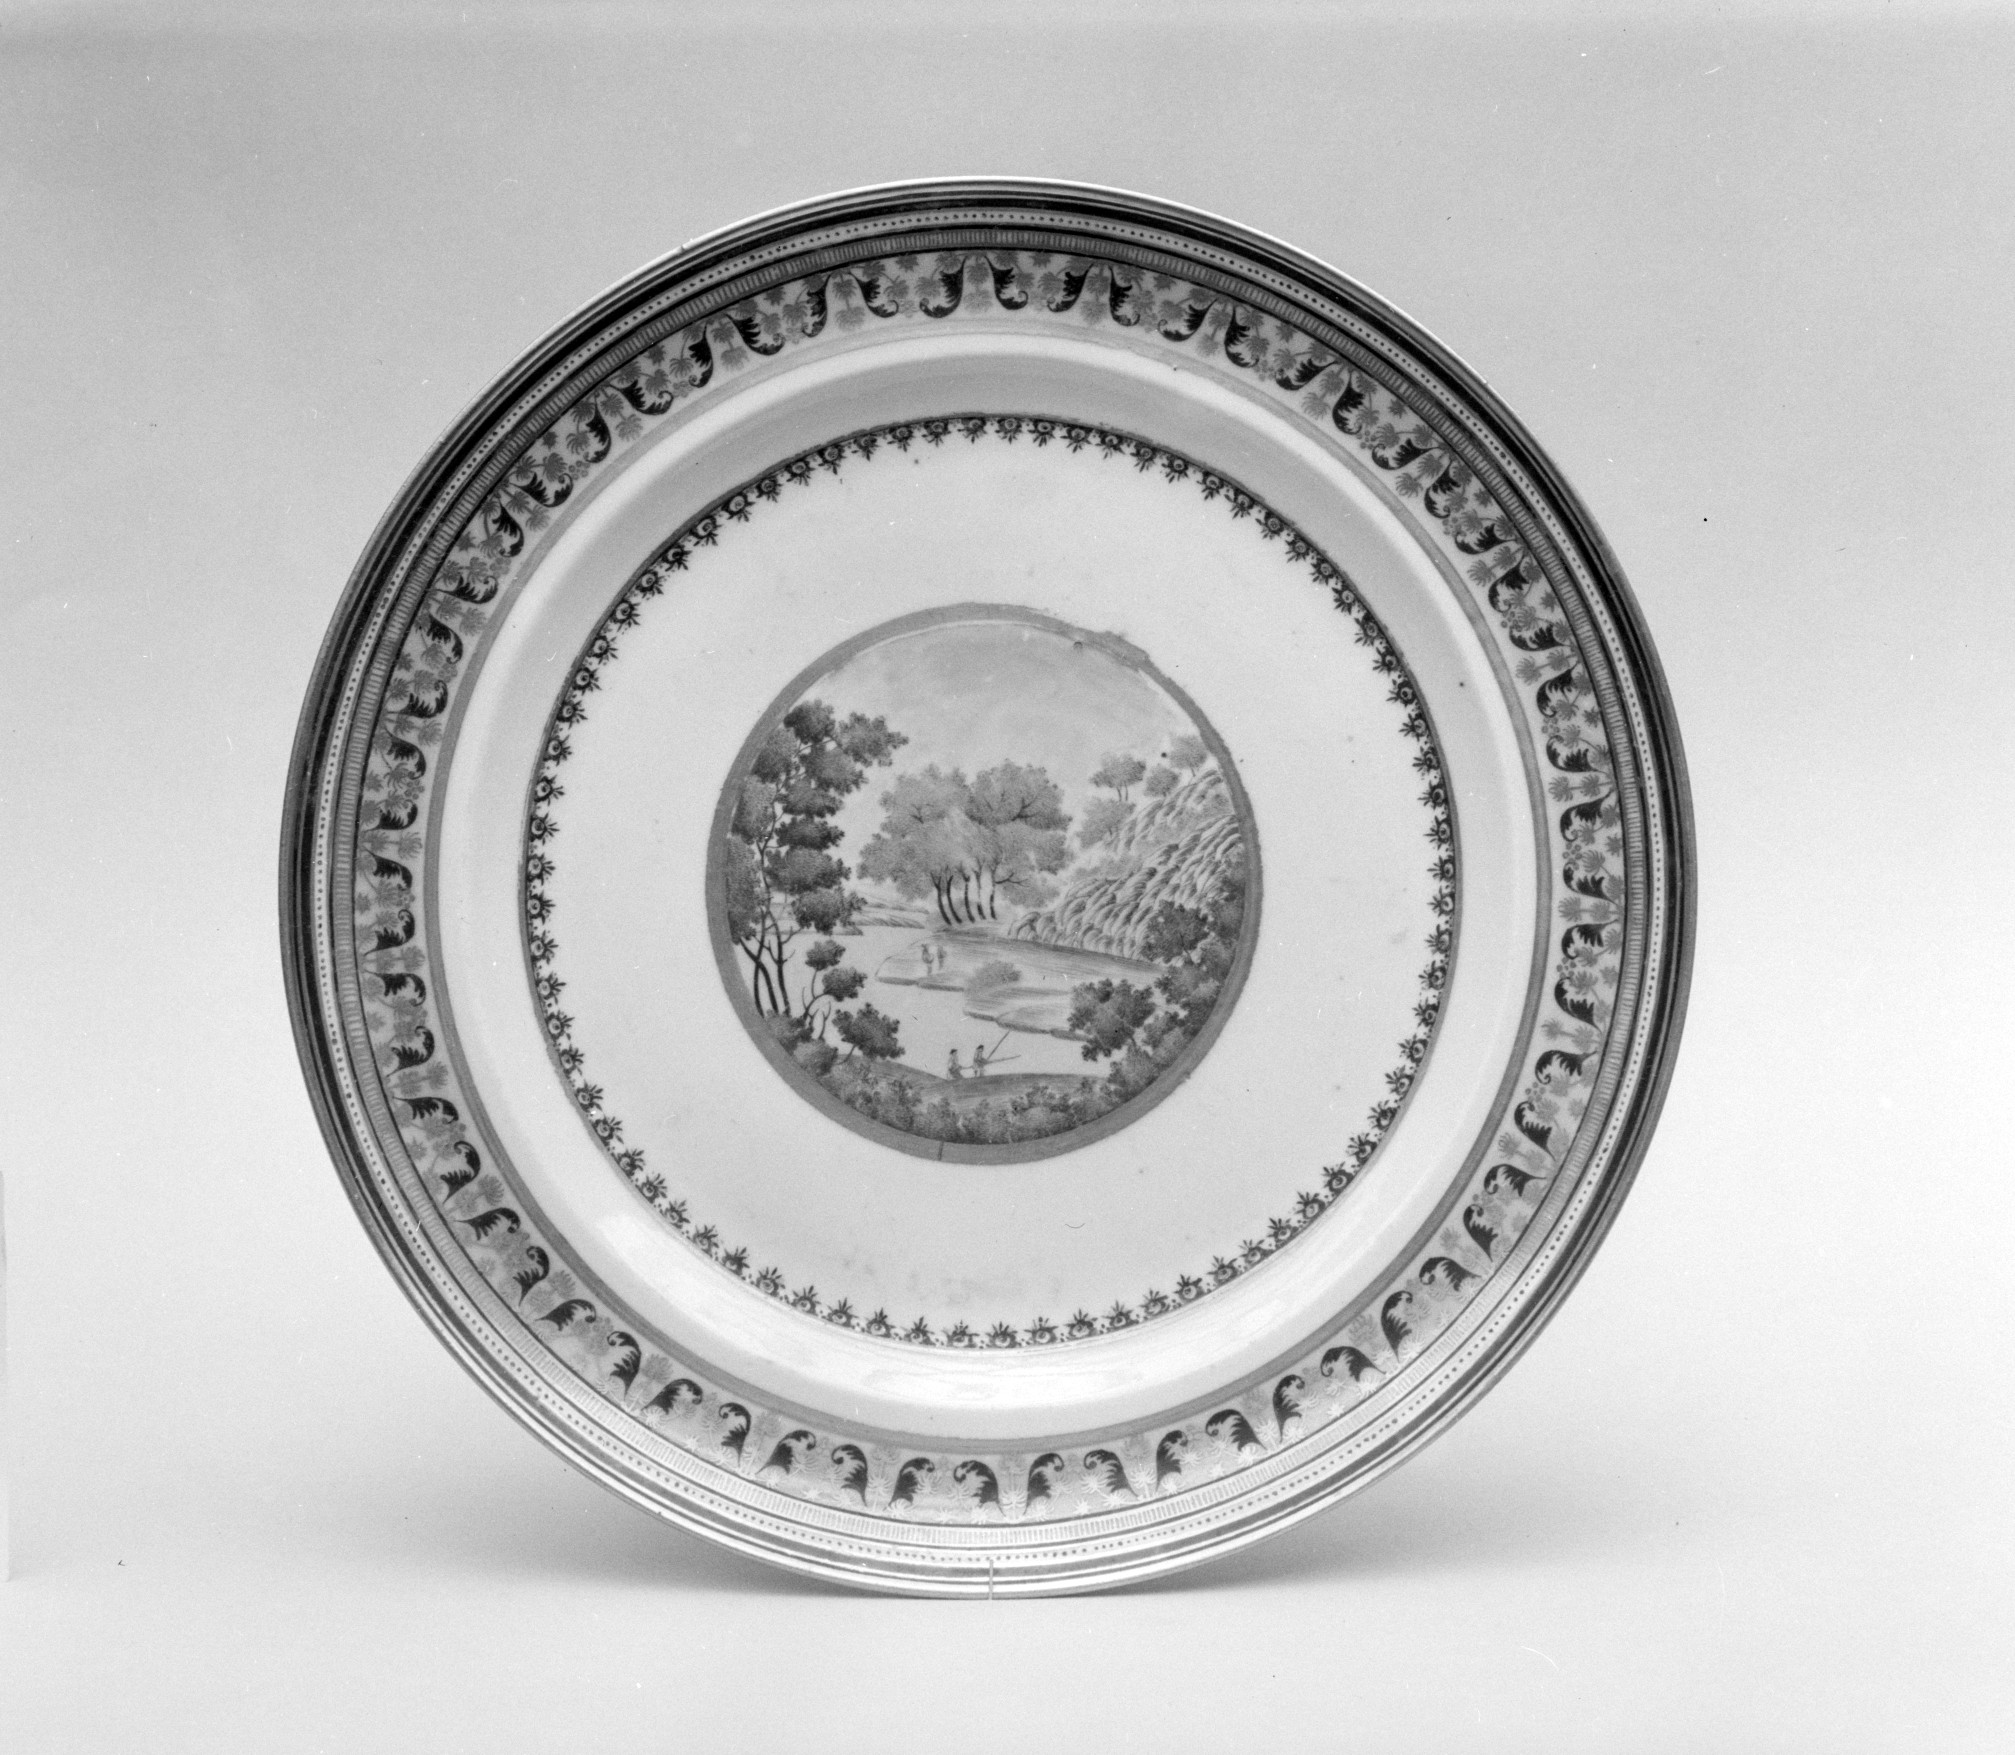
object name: plate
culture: chinese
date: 1800-1830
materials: porcelain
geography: china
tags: landscapes